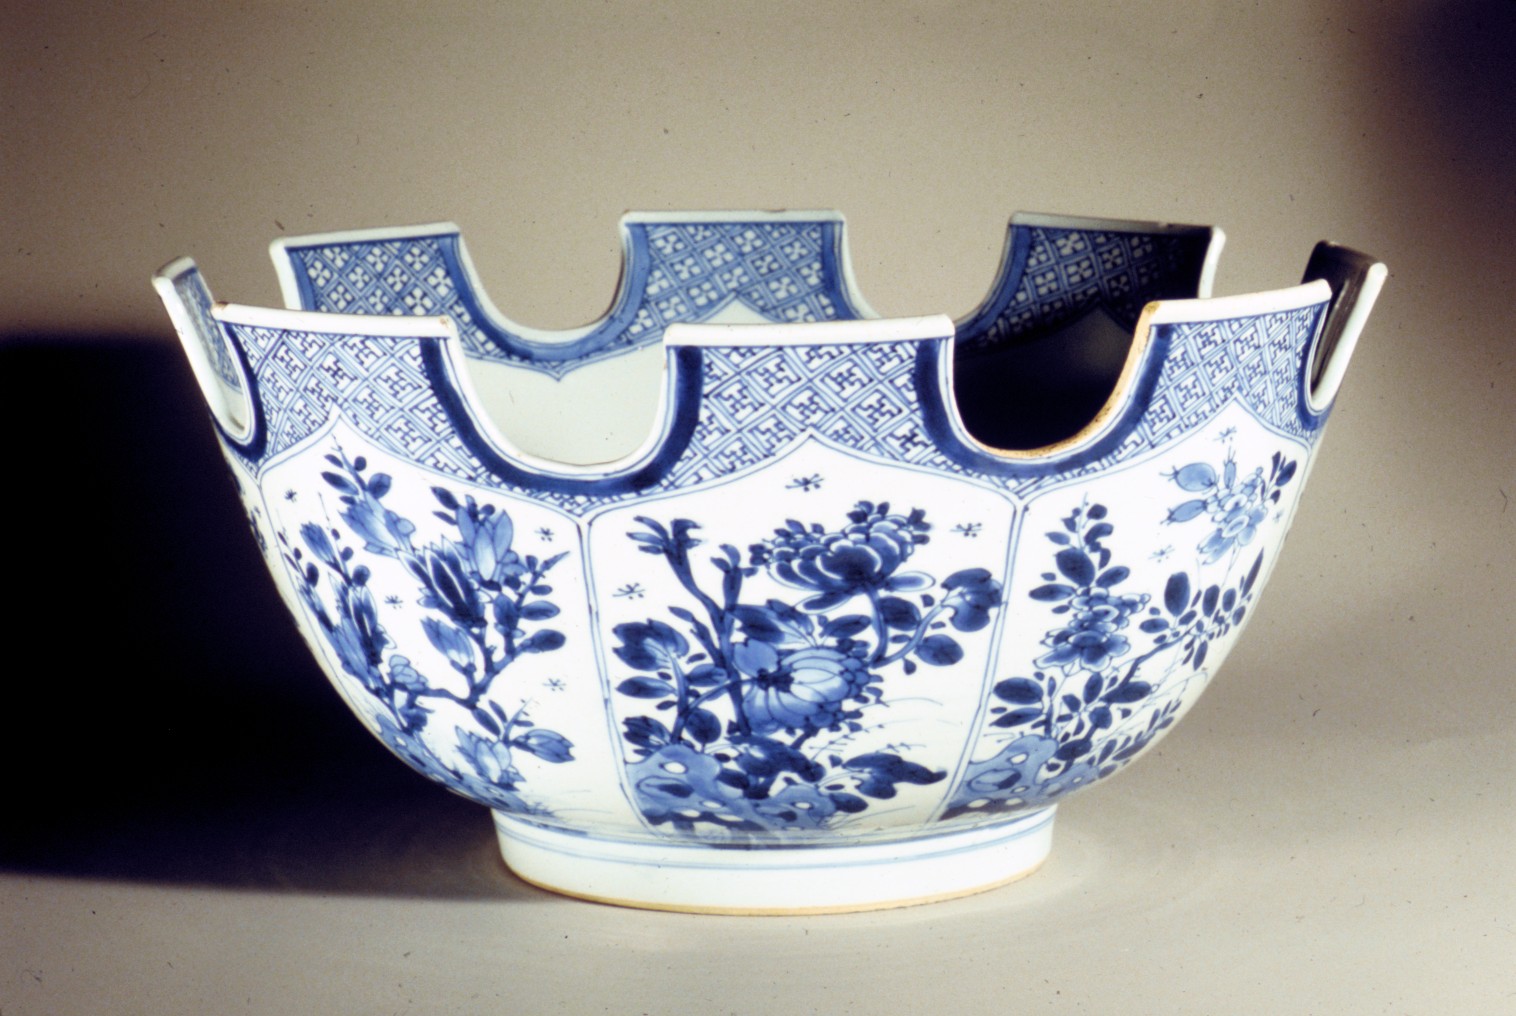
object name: monteith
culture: chinese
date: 1700-1720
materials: porcelain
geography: china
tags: flowers